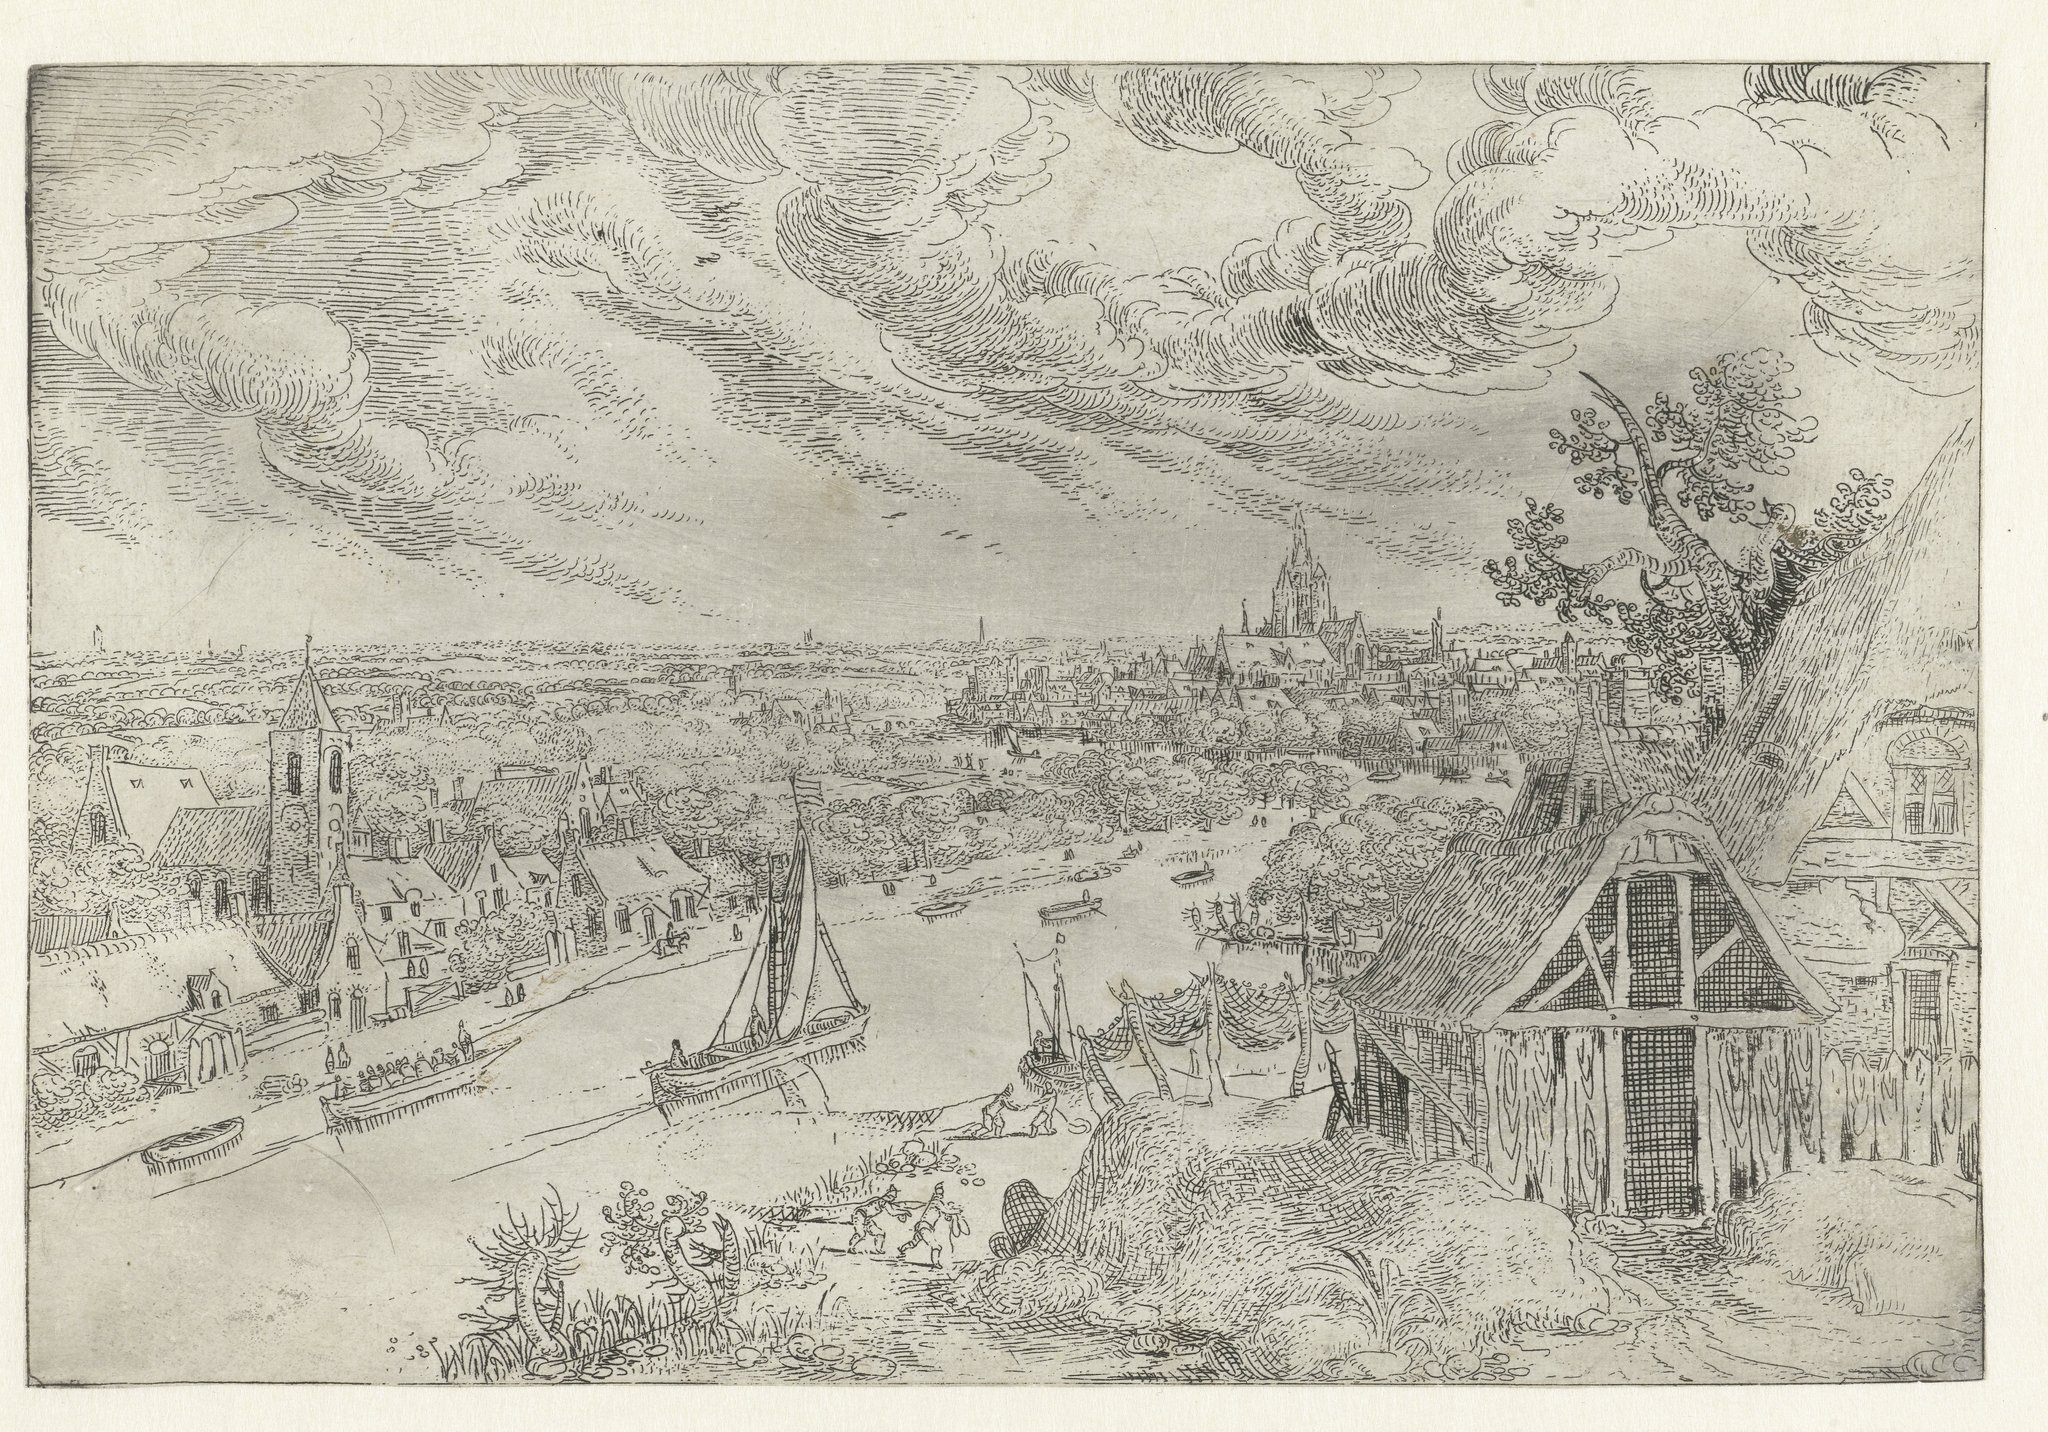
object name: print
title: Zeven landschappen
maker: Anonymous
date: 1550-1580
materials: paper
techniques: etching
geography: southern netherlands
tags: landscapes with waters, waterscapes, seascapes (in the temperate zone)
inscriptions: collector's mark: Lugt 2760, collector's mark: Lugt 2228a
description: Landschap met een rivier lopend van linksvoor naar rechtsachter. Trekschuit en zeil-en roeibootjes in het water. Op de rechteroever lage houten huisjes en vissers. Op de linkeroever een stad met een kerk.